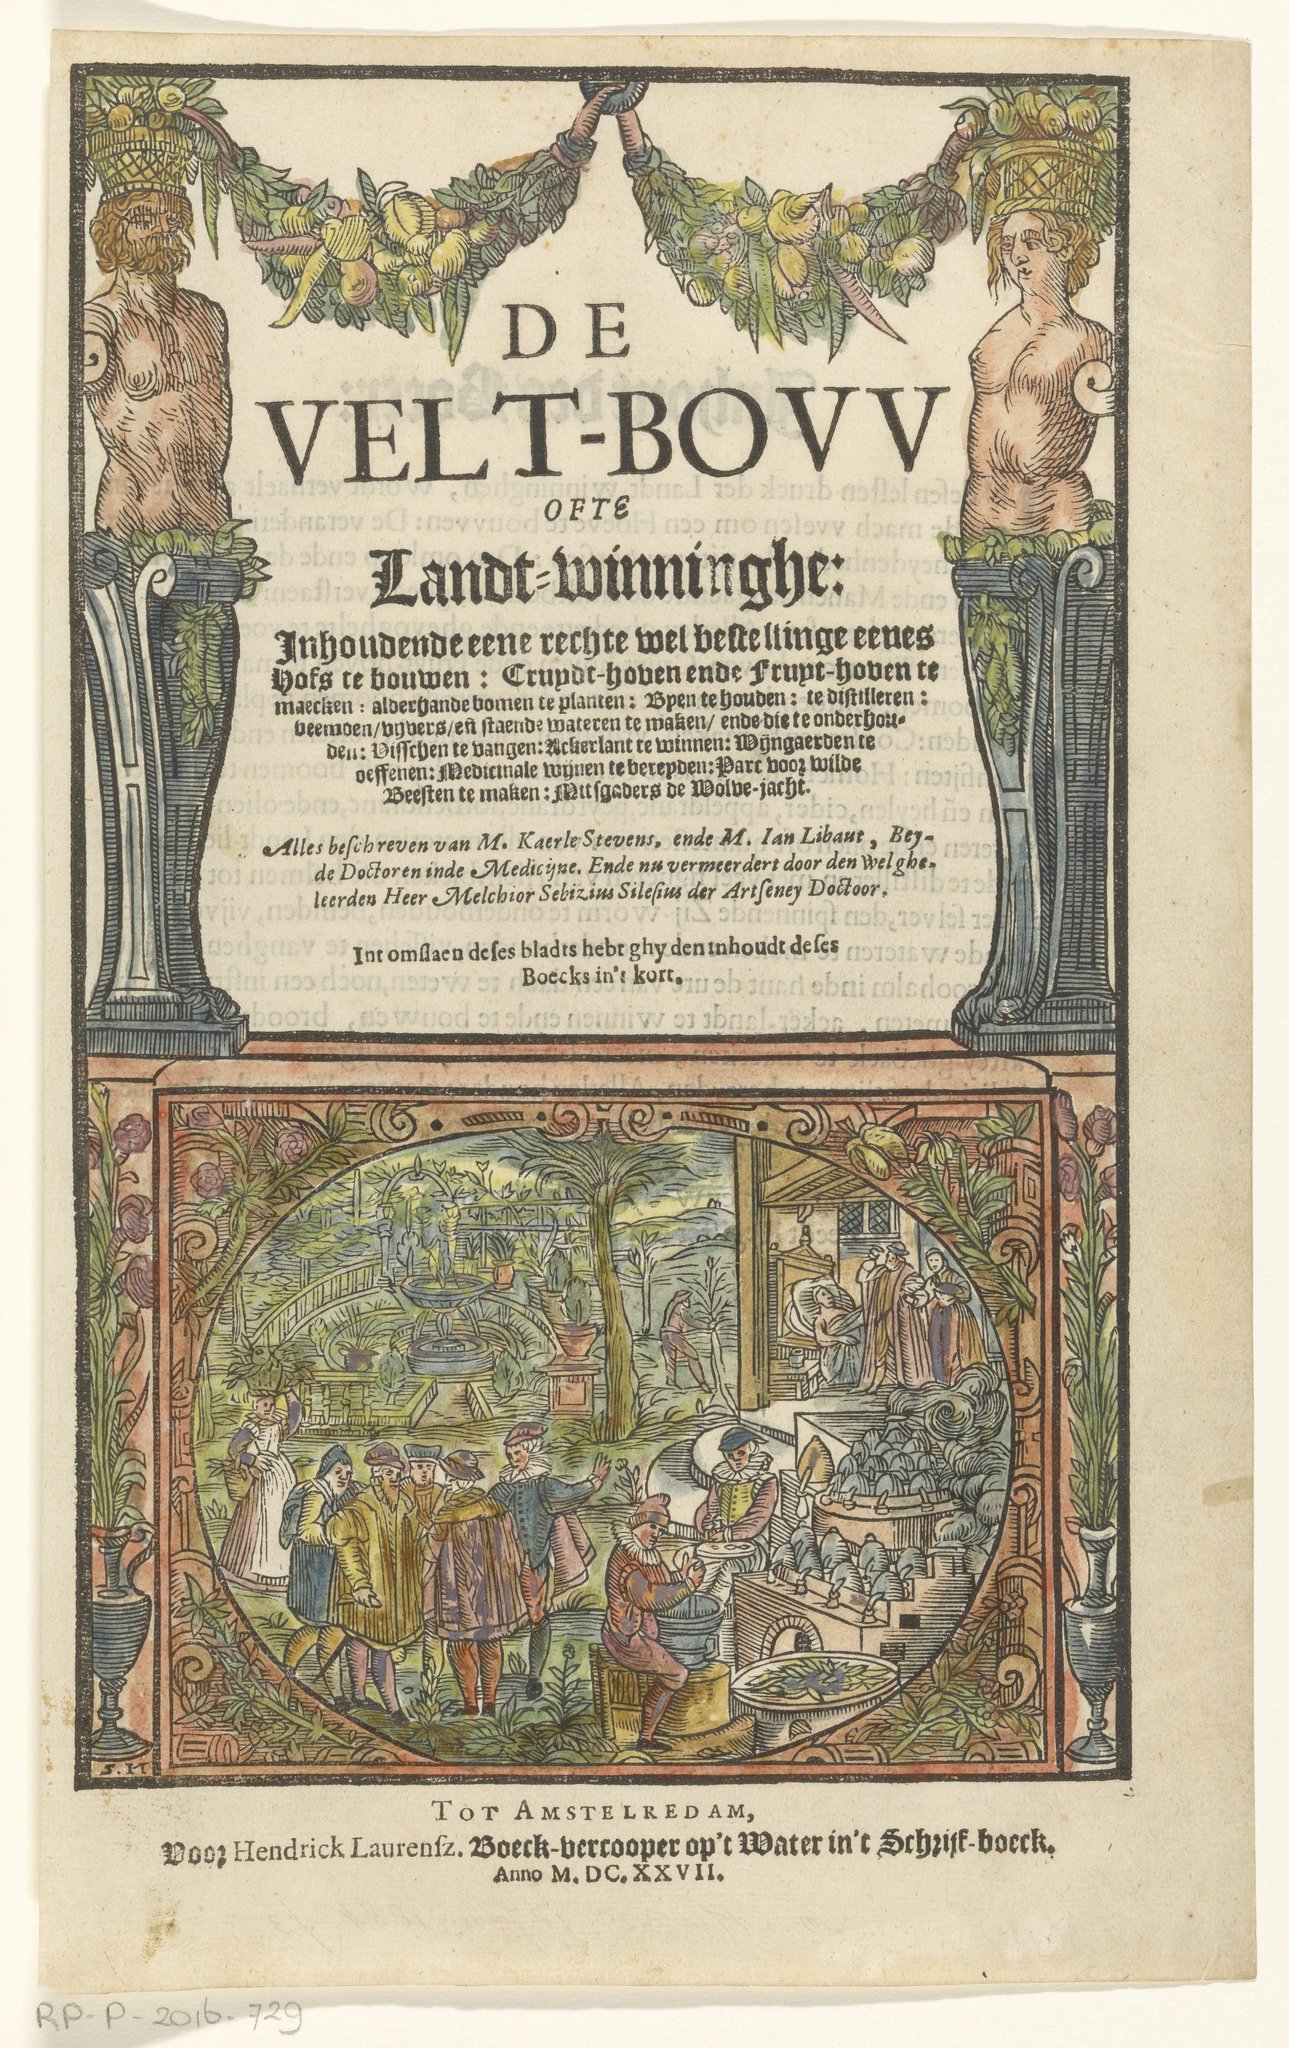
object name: titelblad, titelpagina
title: Diverse scènes in landchap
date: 1627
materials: paper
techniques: hand coloring, letterpress printing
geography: amsterdam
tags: agriculture, landscapes (+ landscape with figures, staffage)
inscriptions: collector's mark: Lugt 2228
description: Ovaal medaillon met diverse scènes in een landschap: een groep pratende mannen, een vrouw met fruitmanden, een fontein in de achtergrond, een zieke op bed en twee mannen bij een oven. Daarboven de titel geflankeerd door twee termen met guirlandes.